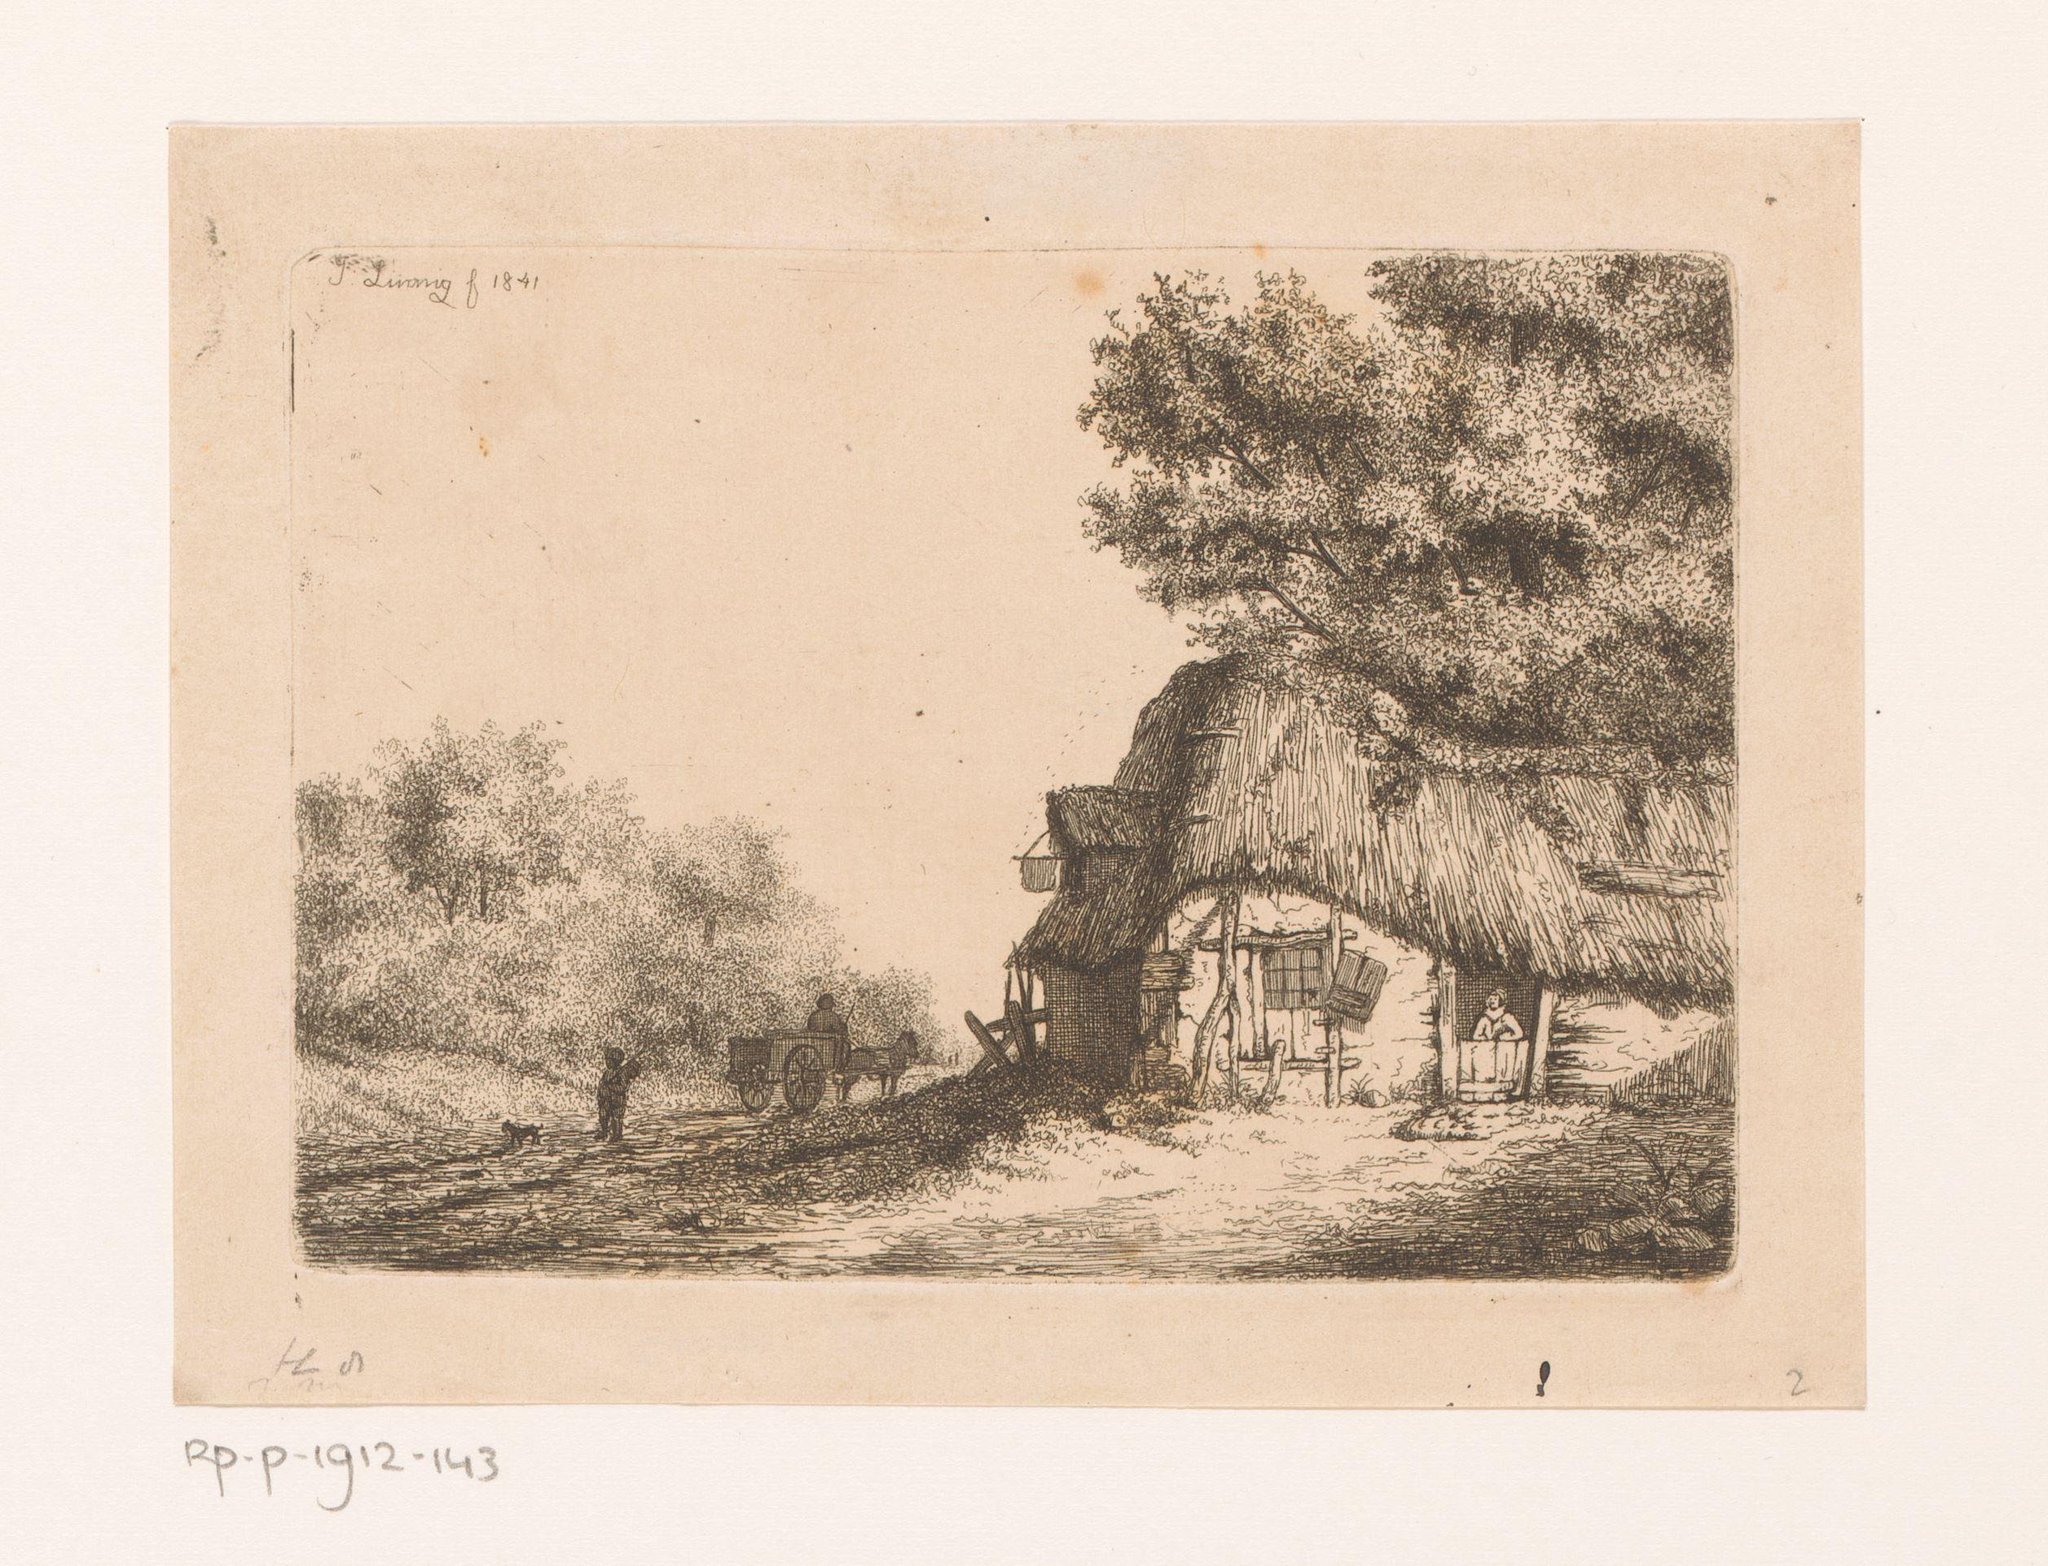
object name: print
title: Boerderij bij Brasschaat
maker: jean théodore joseph linnig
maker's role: draughtsman, print maker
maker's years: 1815-1891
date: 1841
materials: paper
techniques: etching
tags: two-wheeled vehicle drawn by one animal, farm or solitary house in landscape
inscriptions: collector's mark: Lugt 1485, collector's mark: Lugt 2228